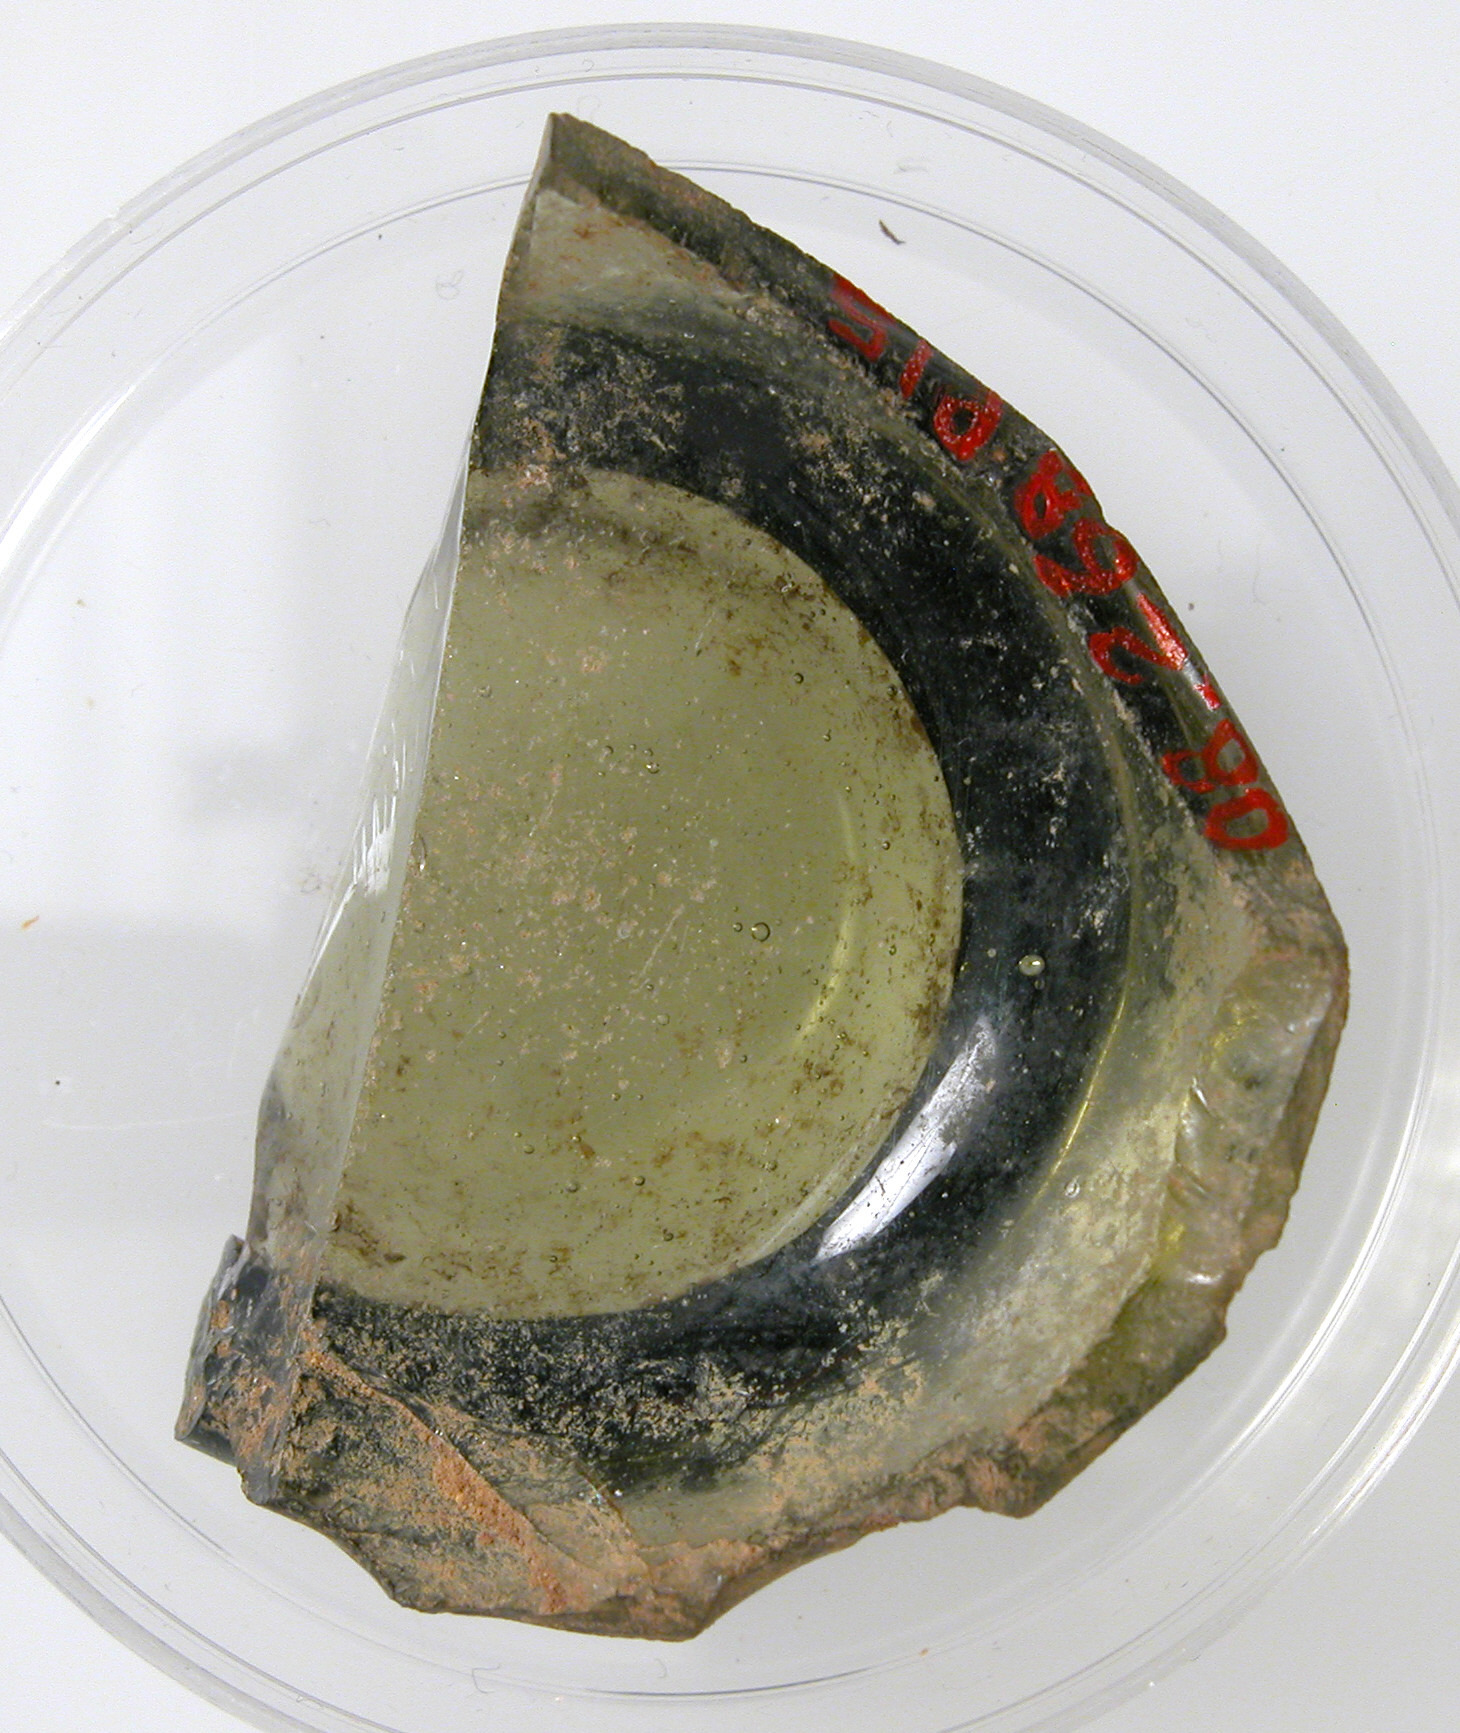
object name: fragment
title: Bottom of a Vessel with Foot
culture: coptic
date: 301-433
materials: glass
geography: egypt